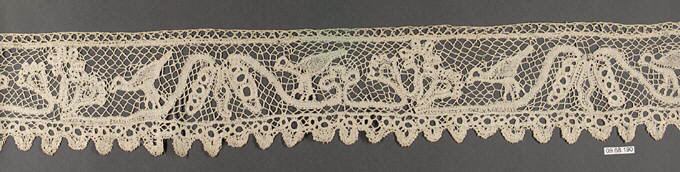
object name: border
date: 1601-1700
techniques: lace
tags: birds,flowers